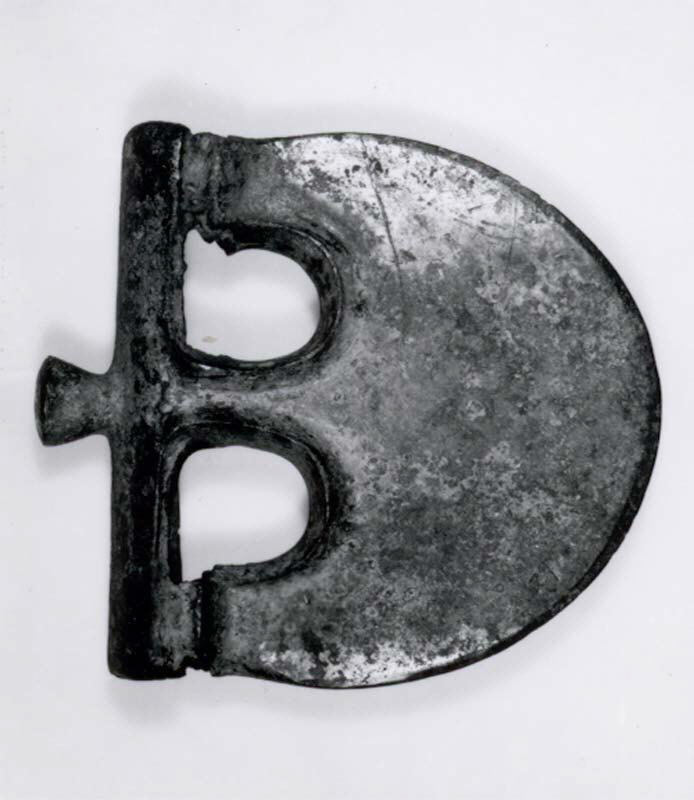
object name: axe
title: Axe head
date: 2333-2001 BCE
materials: bronze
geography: western asia